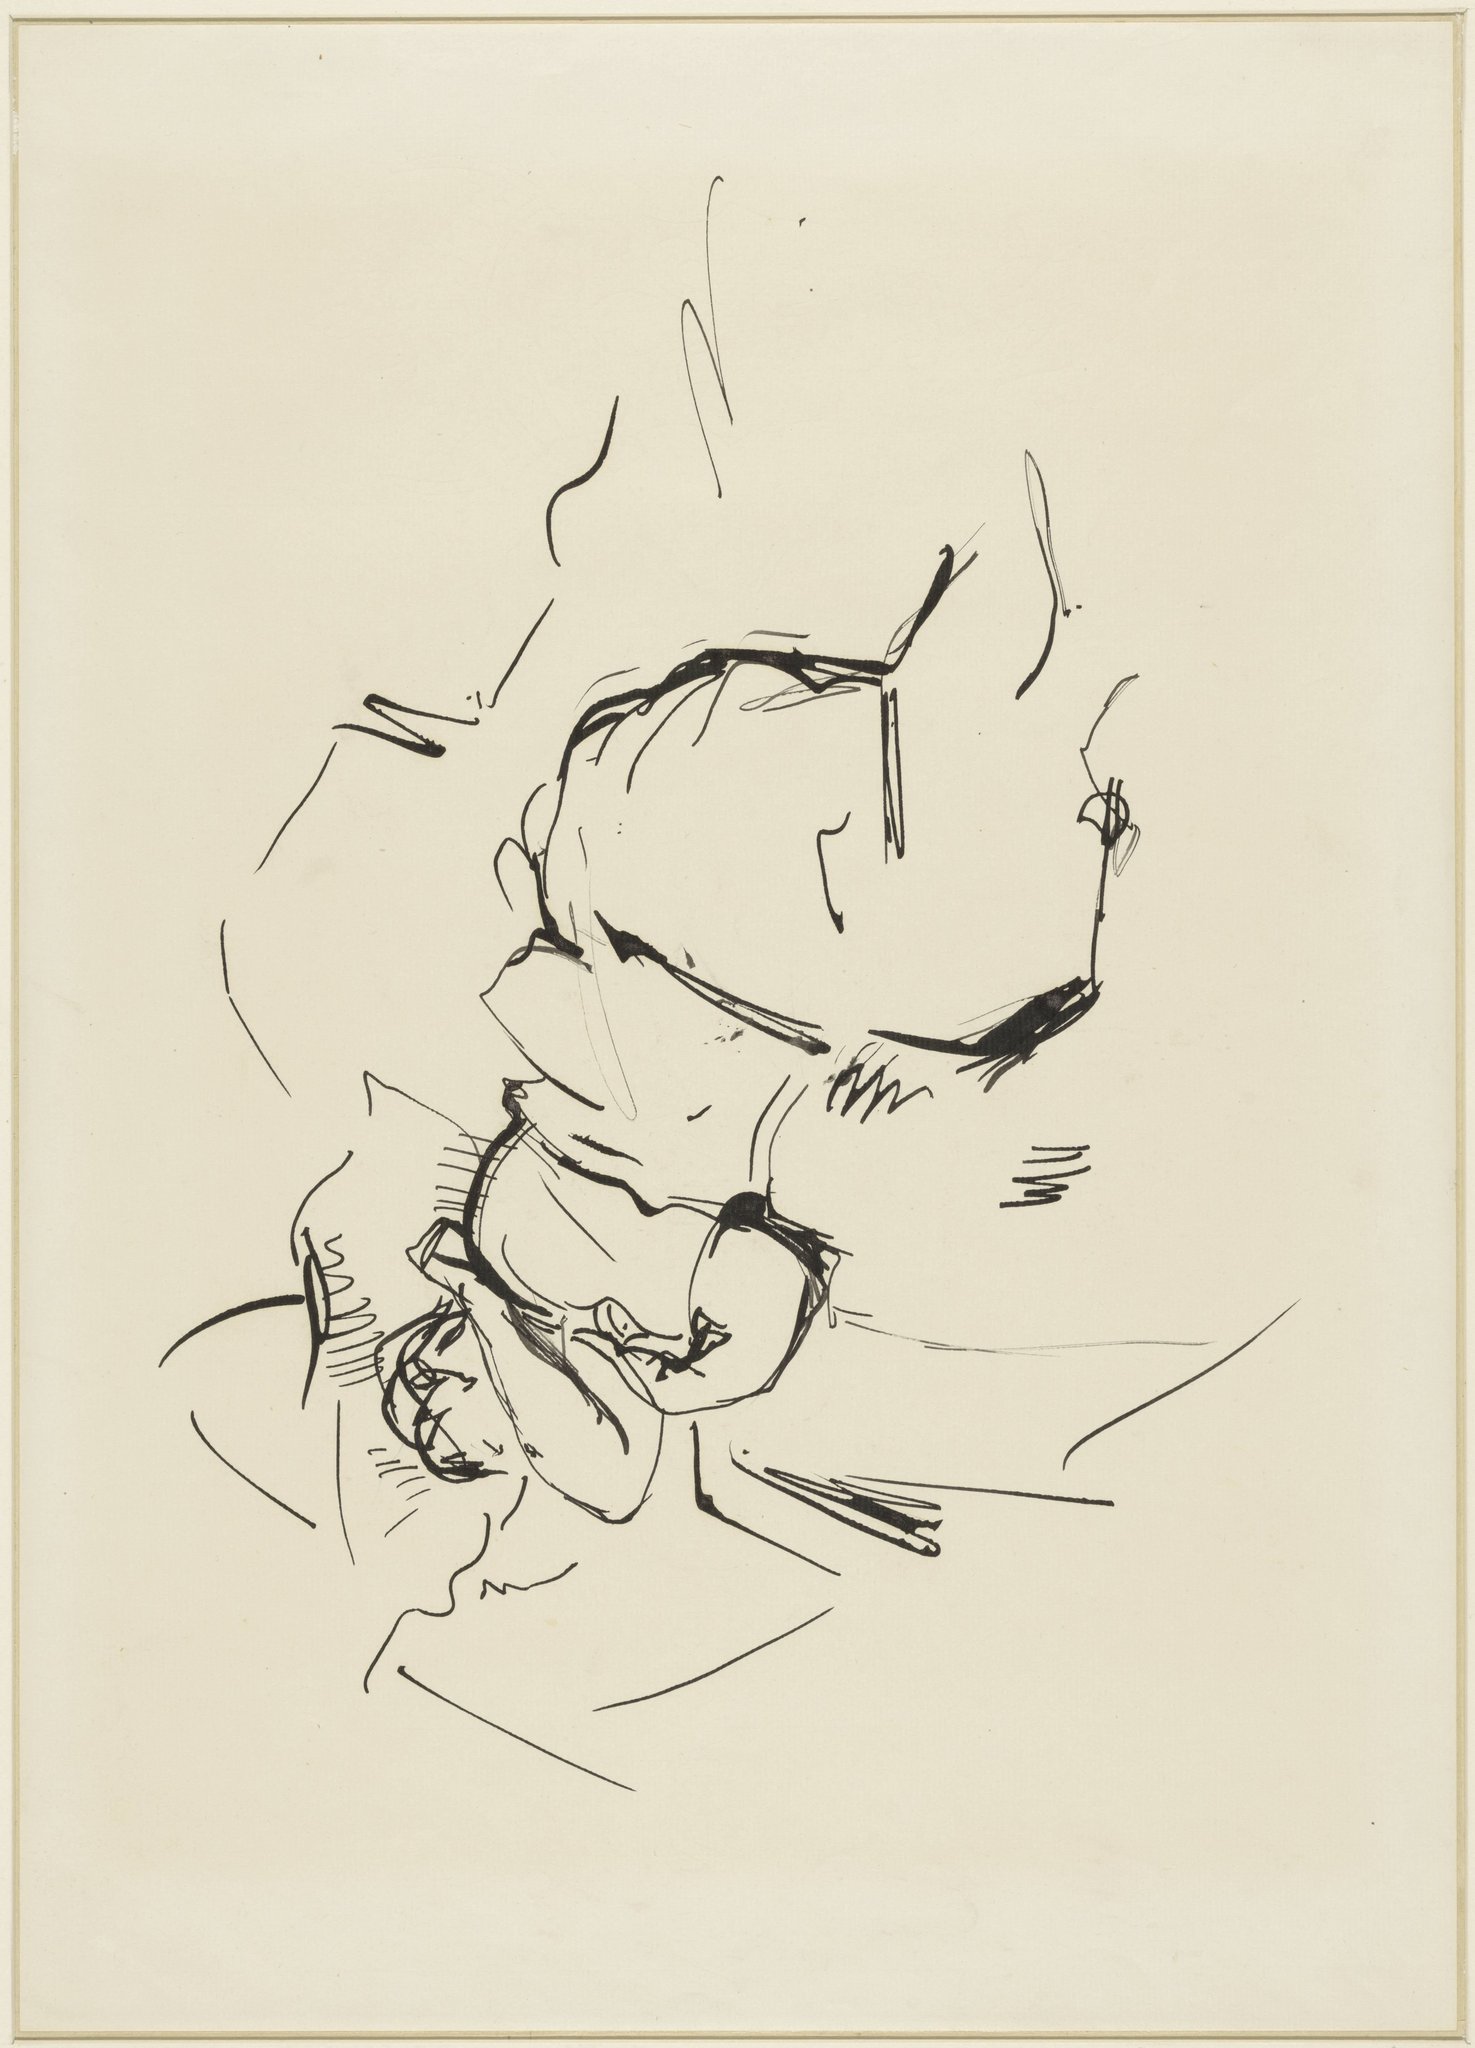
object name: drawing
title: Studie van een liggende vrouw, slapend op een bank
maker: rik wouters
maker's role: draughtsman, print maker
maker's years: 1882-1916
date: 1892-1916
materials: ink, paper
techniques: pen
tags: lying figure - aa - female human figure